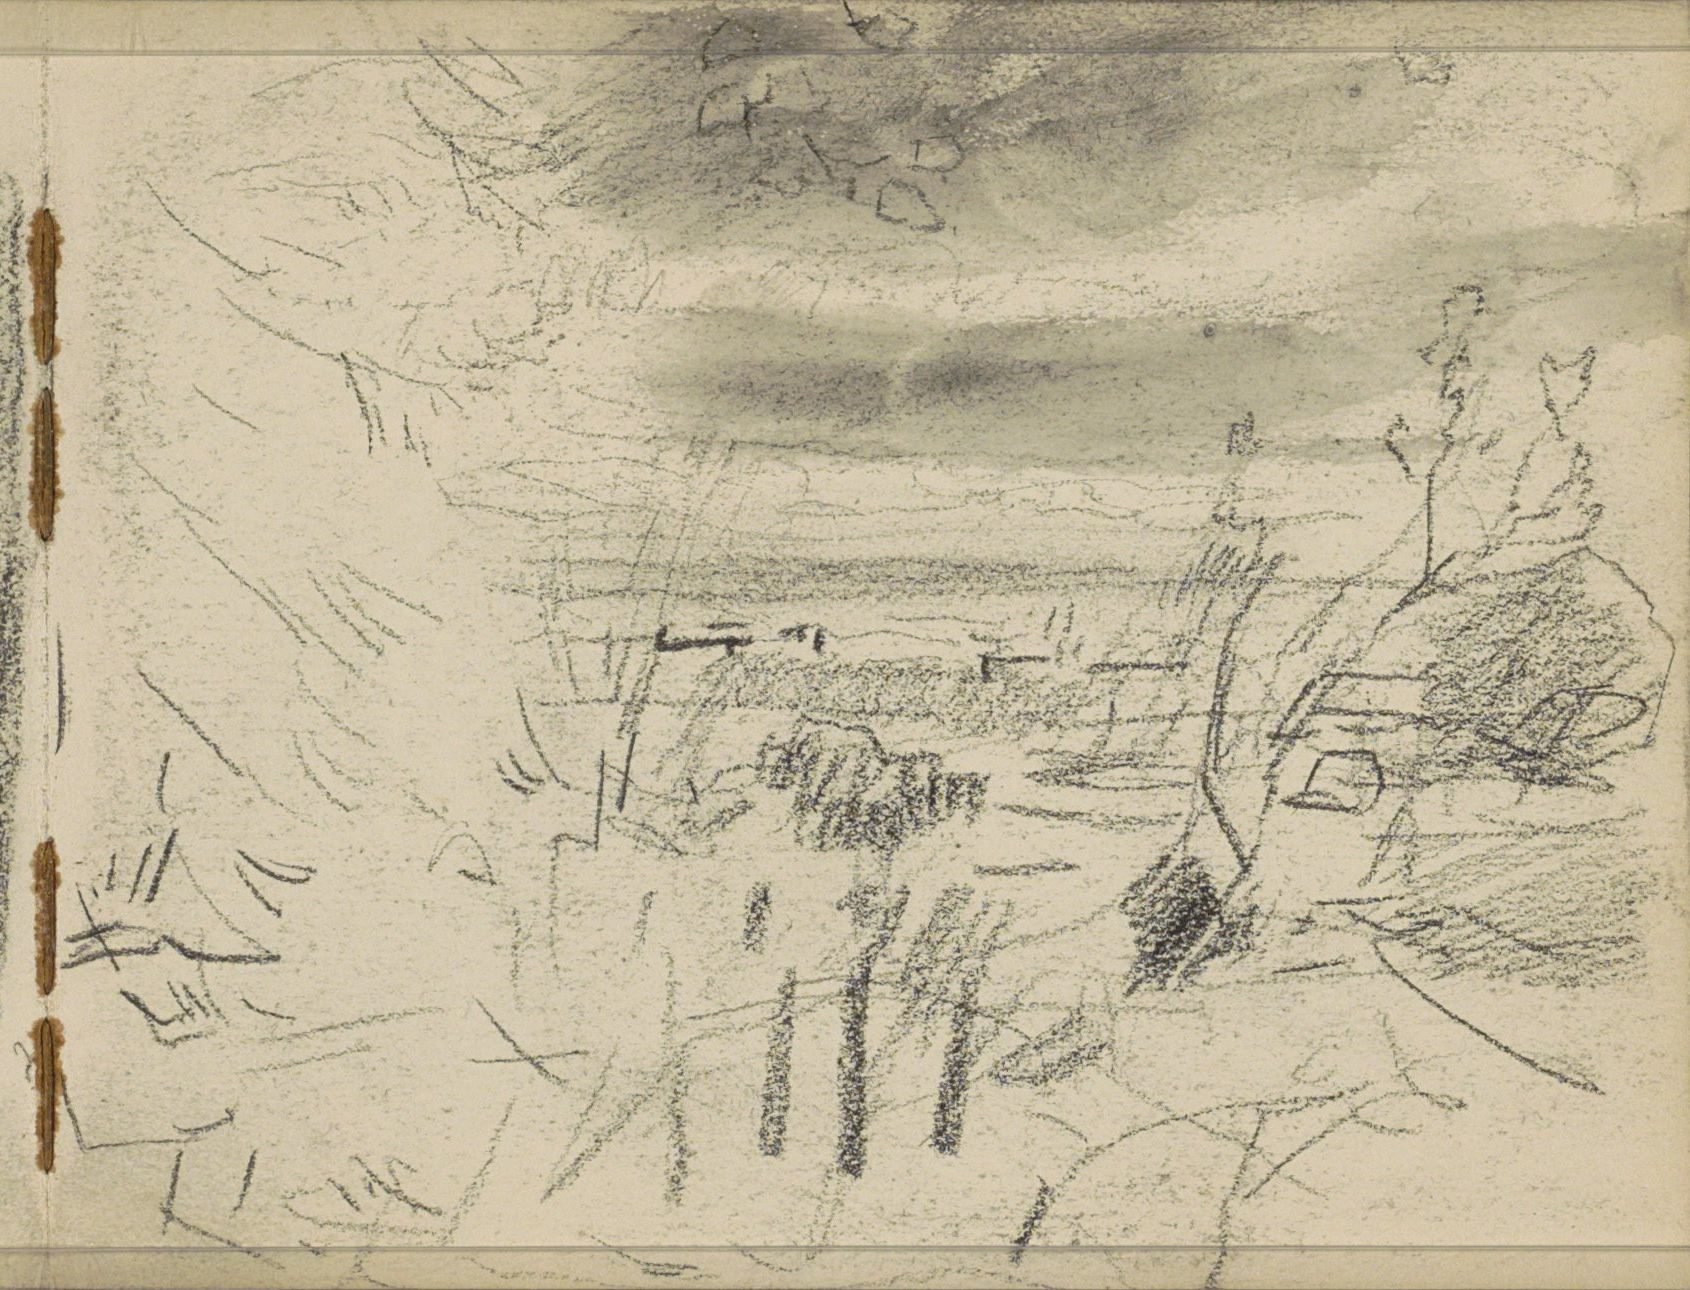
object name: sketchbook leaf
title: Landschap, mogelijk een duinlandschap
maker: johan antonie de jonge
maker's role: draughtsman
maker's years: 1864-1927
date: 1881-1927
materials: chalk, paper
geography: south holland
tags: dune coast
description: Landschap, mogelijk een duinlandschap met in de verte de zee. Blad 15 recto uit een schetsboek met 34 bladen.